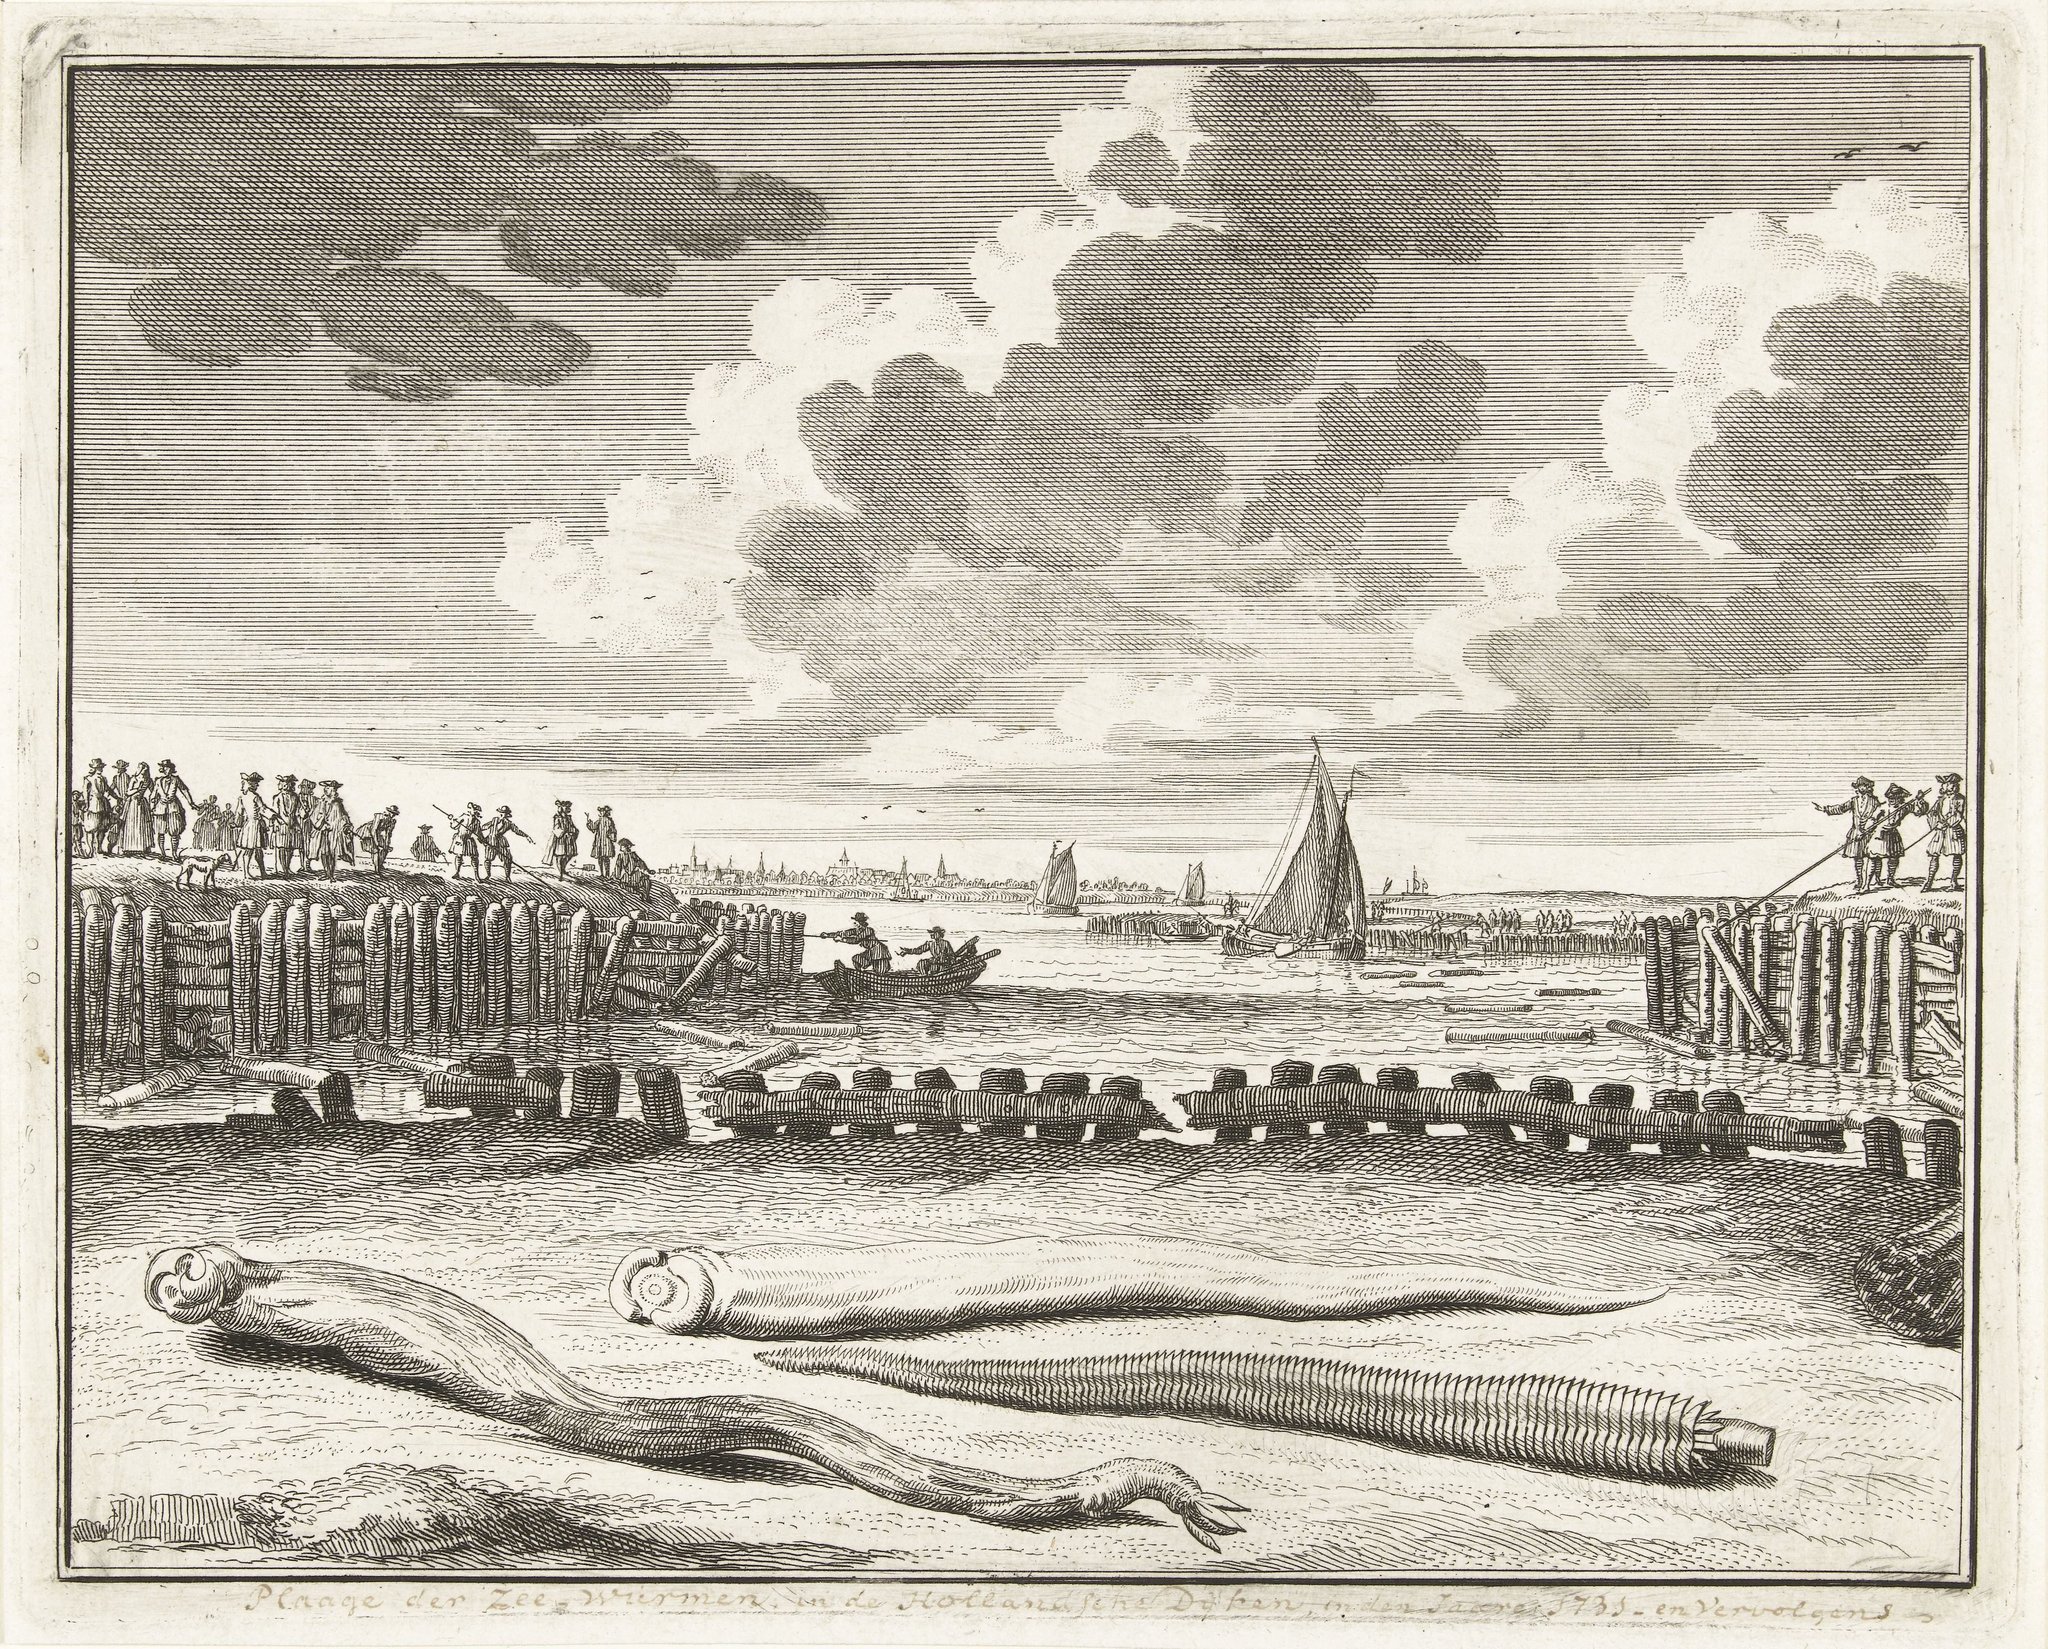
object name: print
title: Paalwormen die de dijkbeschoeiïngen aantasten, 1731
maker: abraham zeeman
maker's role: print maker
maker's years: 1695-1754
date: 1731-1733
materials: paper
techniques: etching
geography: northern netherlands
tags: worms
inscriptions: collector's mark: Lugt 2228, inscription: ‘Plaage der Zee wurmen in de Hollandsche Dyken, in den Jaar a. 1733 - en vervolgens’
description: Gebruikt als illustratie in: P. Massuet. Wetenswaardig onderzoek over den oorsprongk (...) en de verbazende menigte der (...) kokerwurmen, die de dykpalen en schepen van enige der Vereenigde Nederlandsche Provintsien doorboren. Amsterdam, A. Wor en erven G. onder de Linden, 1733.